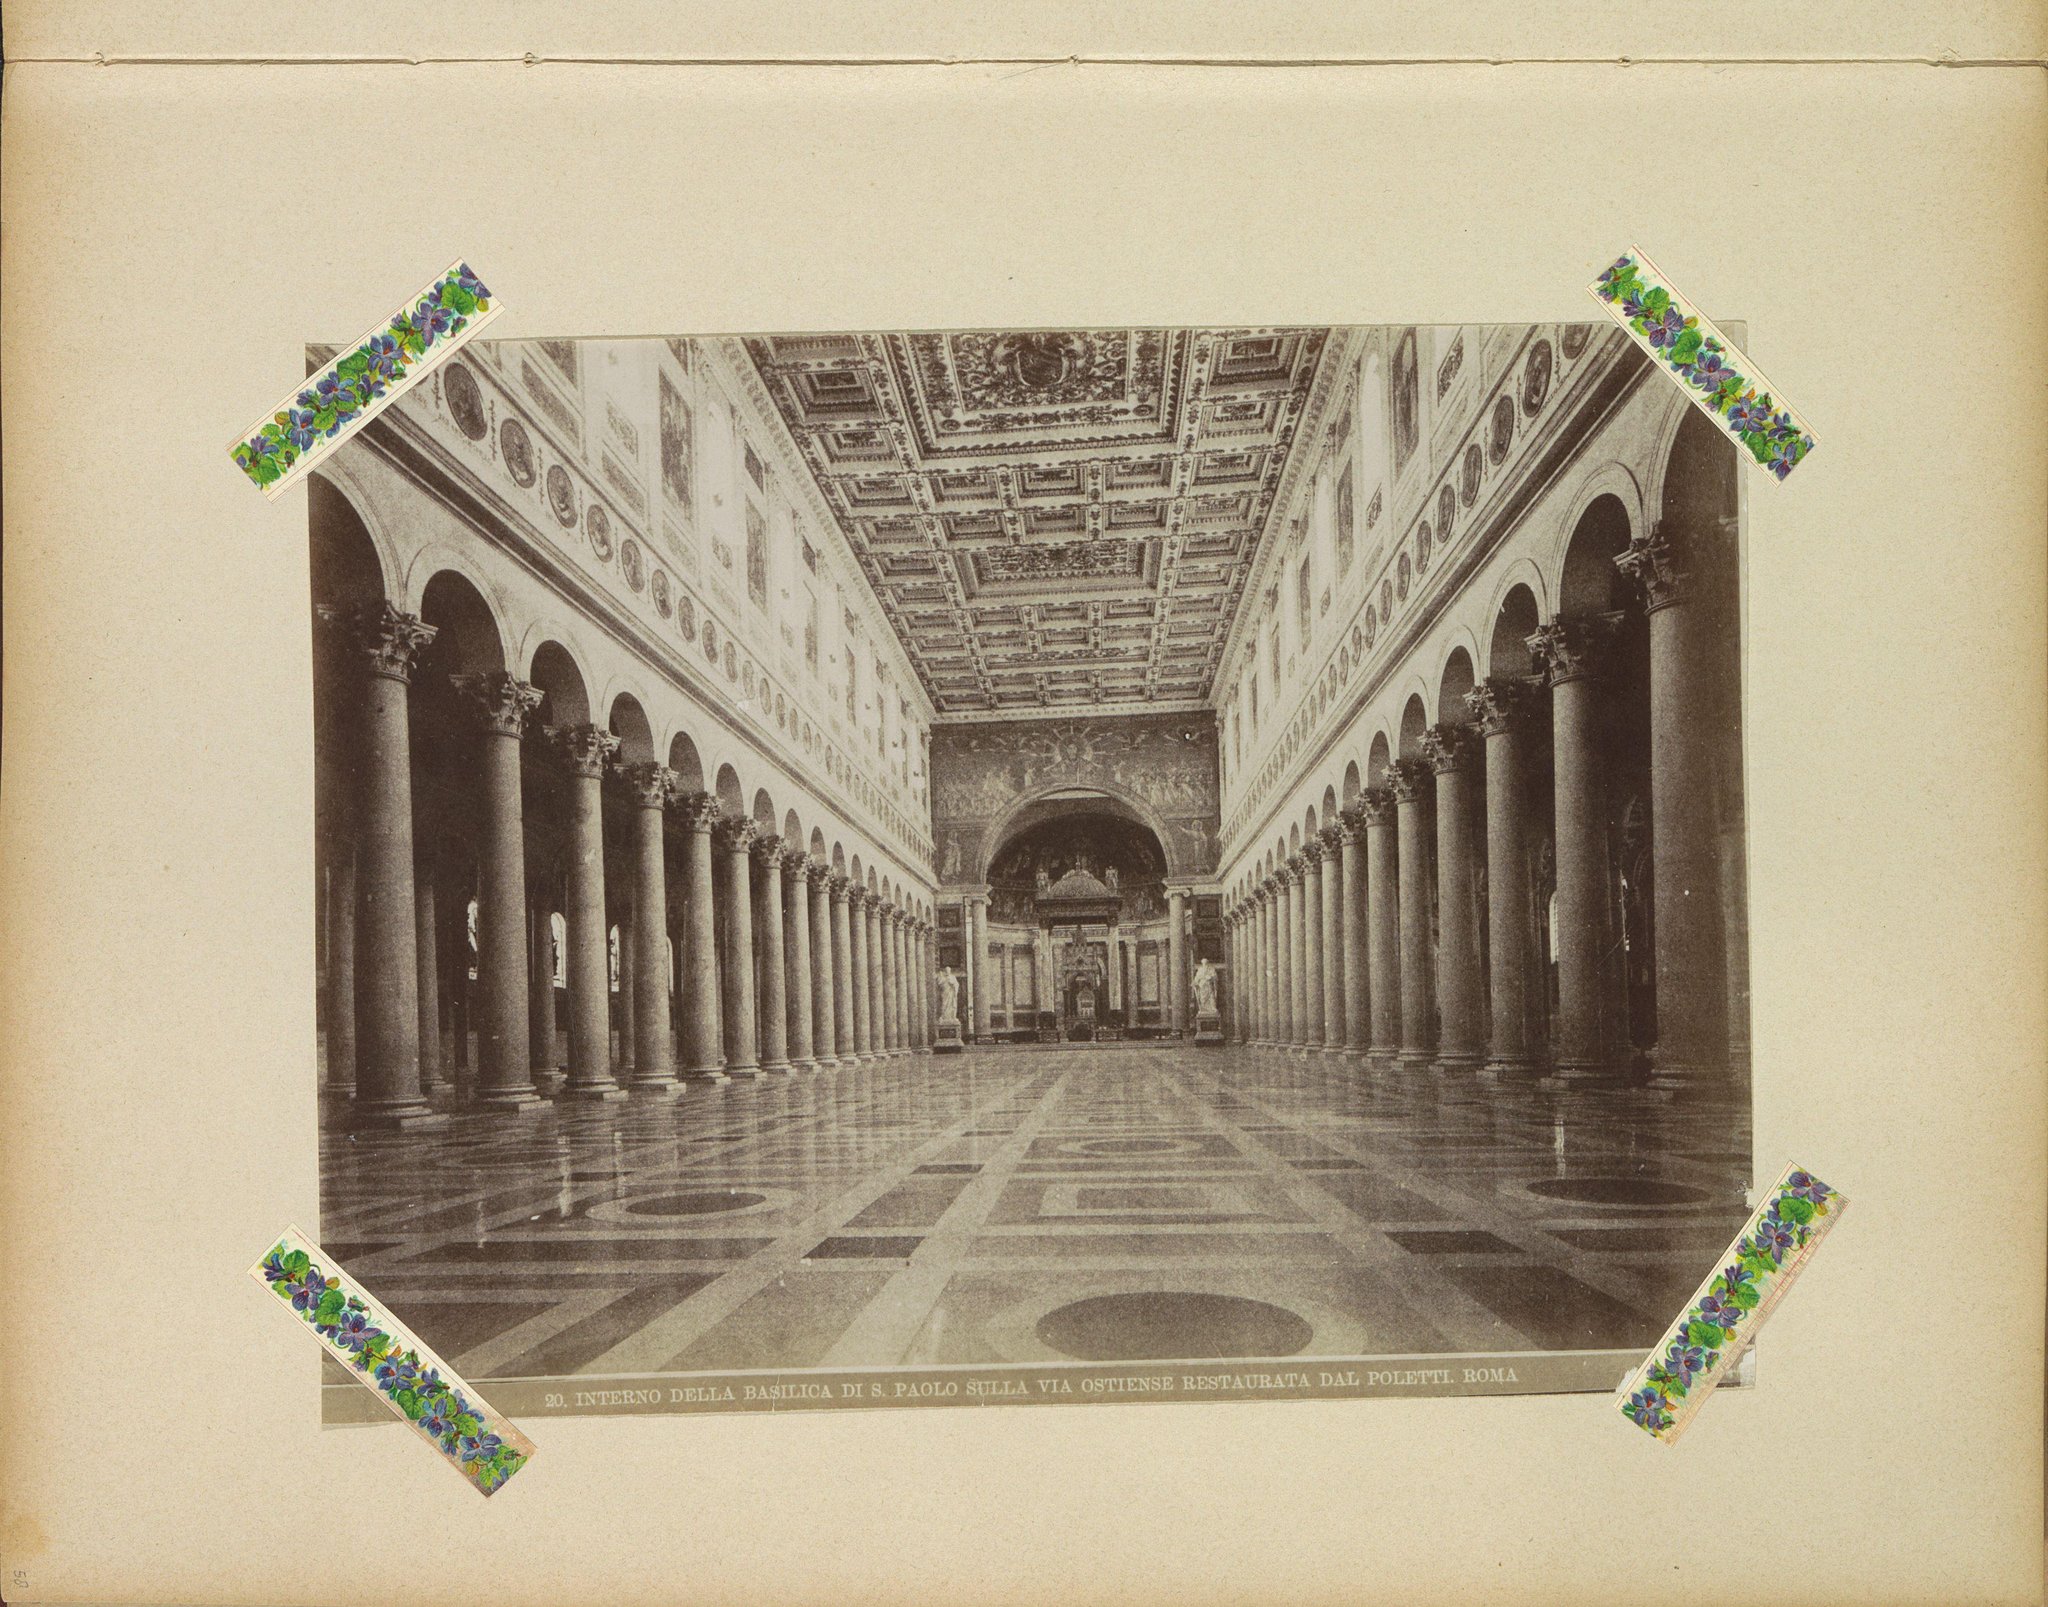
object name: photograph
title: Interno della Basilica di S. Paolo sulla Via Ostiense restaurata dal Poletti. Roma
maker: Anonymous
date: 1860-1900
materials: photographic support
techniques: albumen print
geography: sint-paulus buiten de muren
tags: colonnade, interior of church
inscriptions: number: ‘20’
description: Onderdeel van Fotoalbum met opnames van bezienswaardigheden in Italiaanse steden en van kunstwerken.